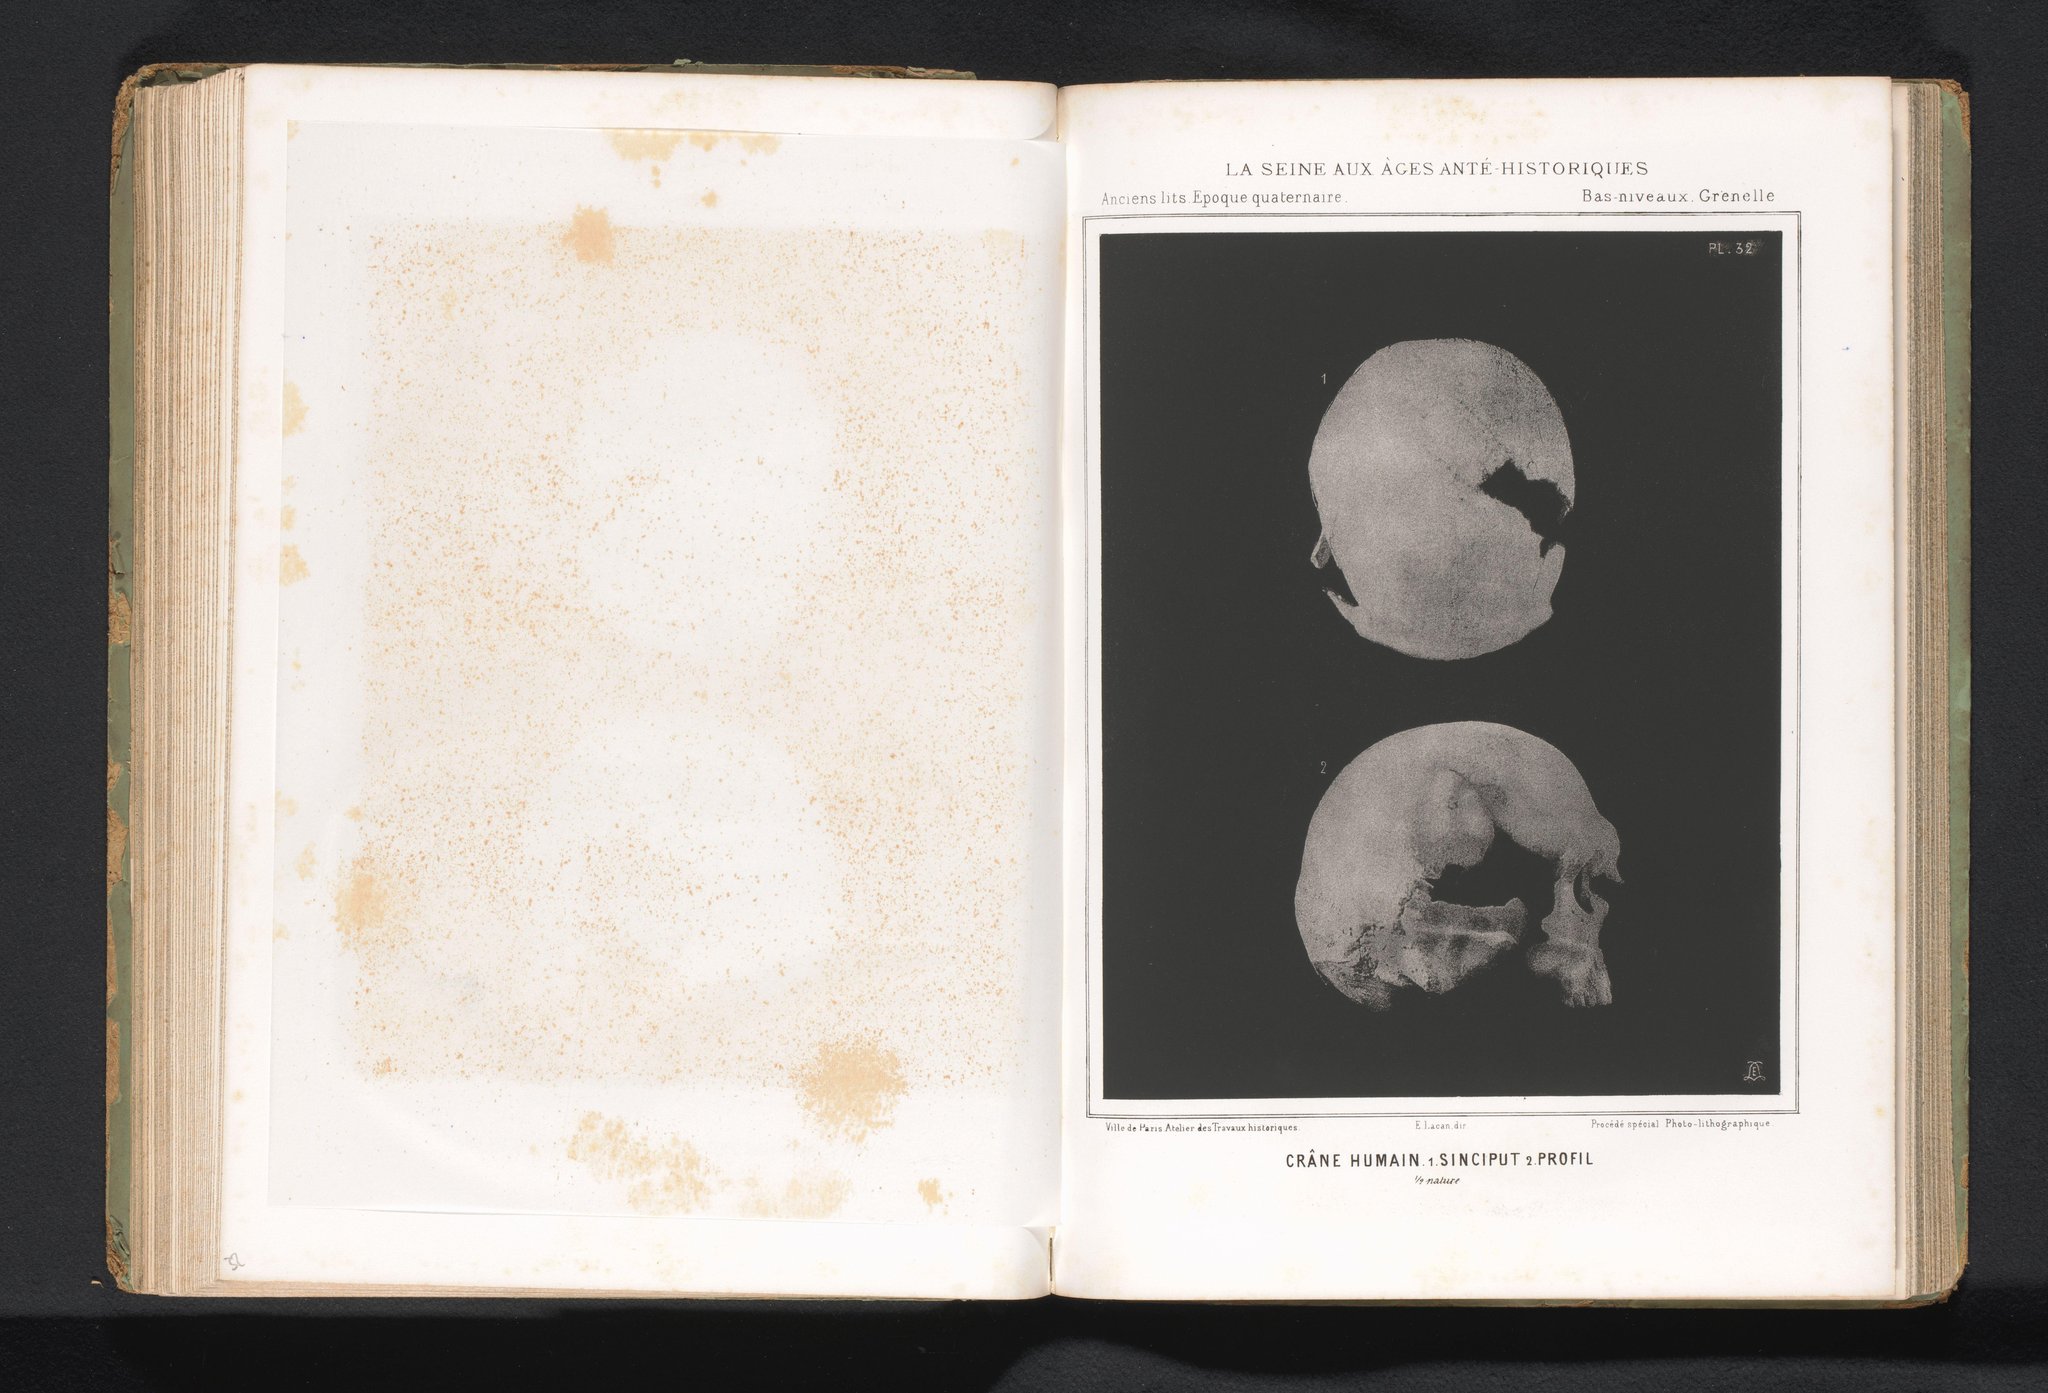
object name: photomechanical print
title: Twee aanzichten van een menselijke schedel, bovenaanzicht en en profil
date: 1864-1869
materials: paper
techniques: photolithography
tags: (human) skull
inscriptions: inscription: ‘CRÂNE HUMAIN. 1. SINCIPUT, 2. PROFIL’, monogram: ‘E’, inscription: ‘PL. 32’, inscription: ‘Procédé spécial photo-lithographique’, inscription: ‘1/2 nature’